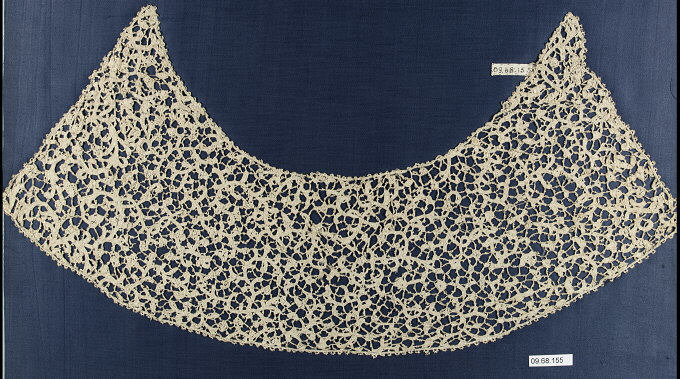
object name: collar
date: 1601-1700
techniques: lace